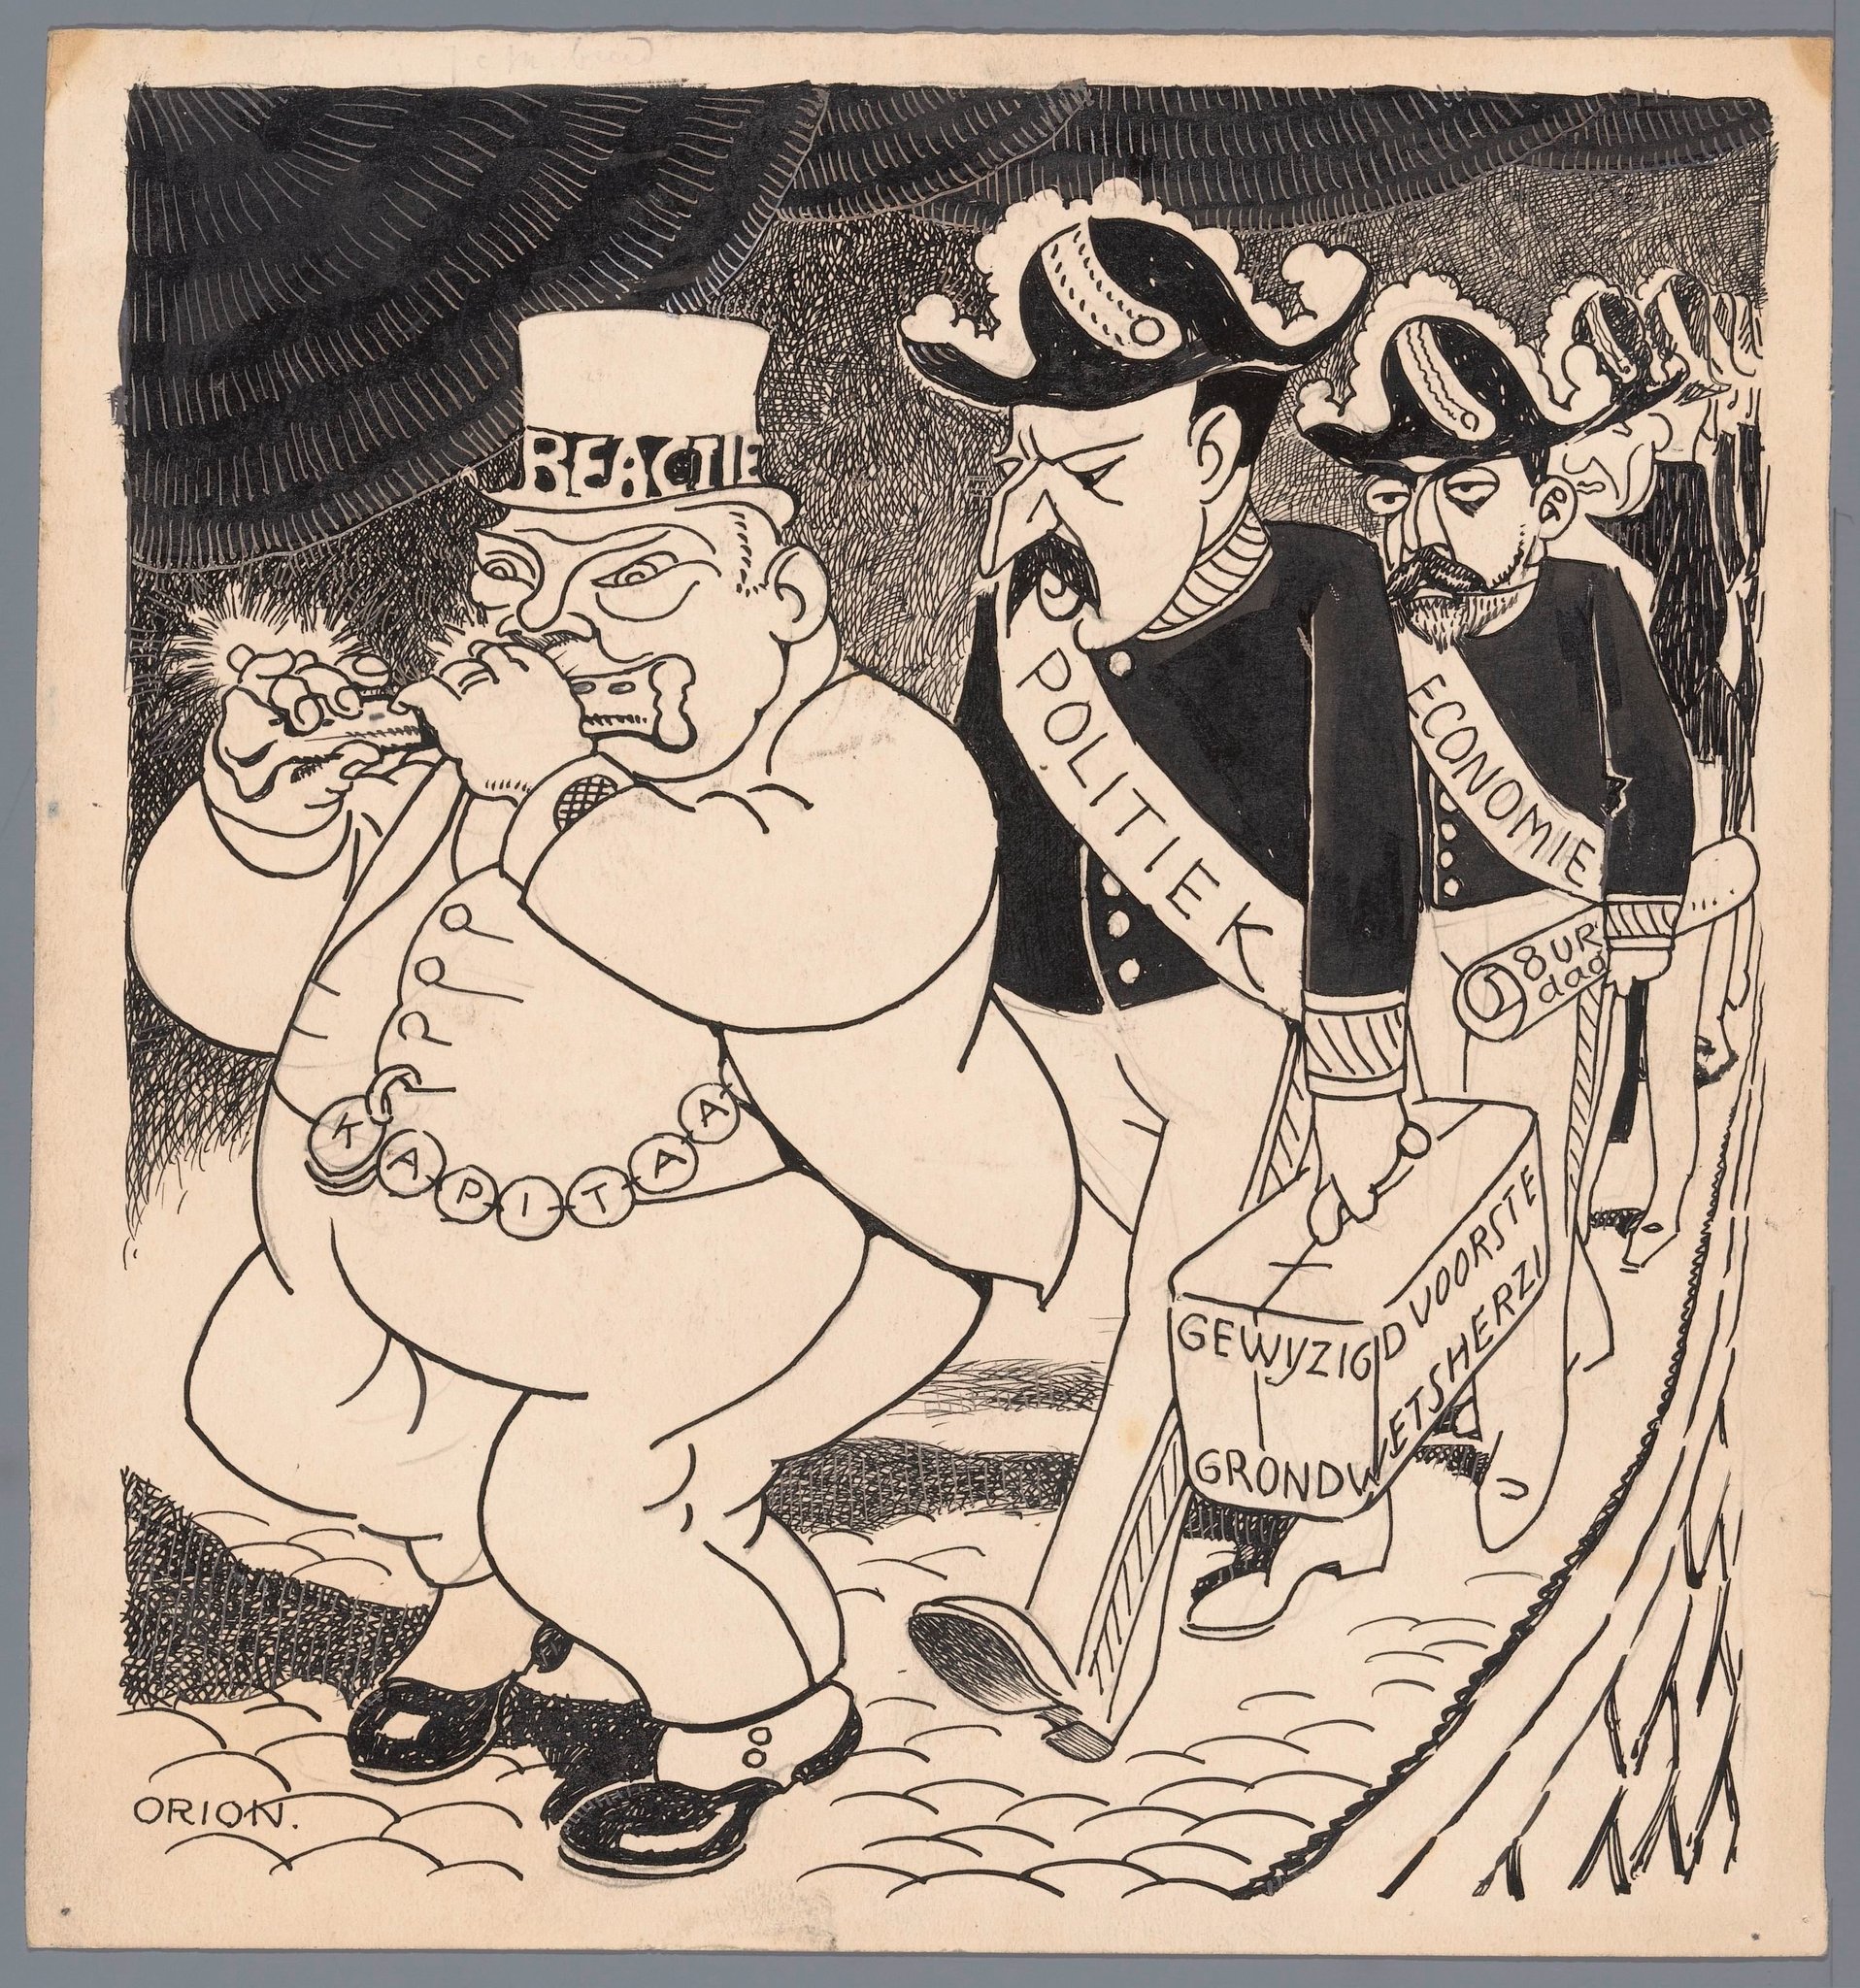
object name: drawing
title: Politiek volgt het pijpen van het Kapitaal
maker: patricq kroon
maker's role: draughtsman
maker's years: 1862-1941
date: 1900-1935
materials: ink, paint, paper, pencil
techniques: brush, pen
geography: netherlands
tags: political caricatures and satires, flute, aulos, tibia, netherlands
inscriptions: inscription: ‘En Satan pijpt! ...’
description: Een dikke duivel aangeduid als 'reactie' en 'kapitaal' speelt op een fluit en wordt gevolgd door een stoet van ministers. Ontwerp voor een politieke spotprent.